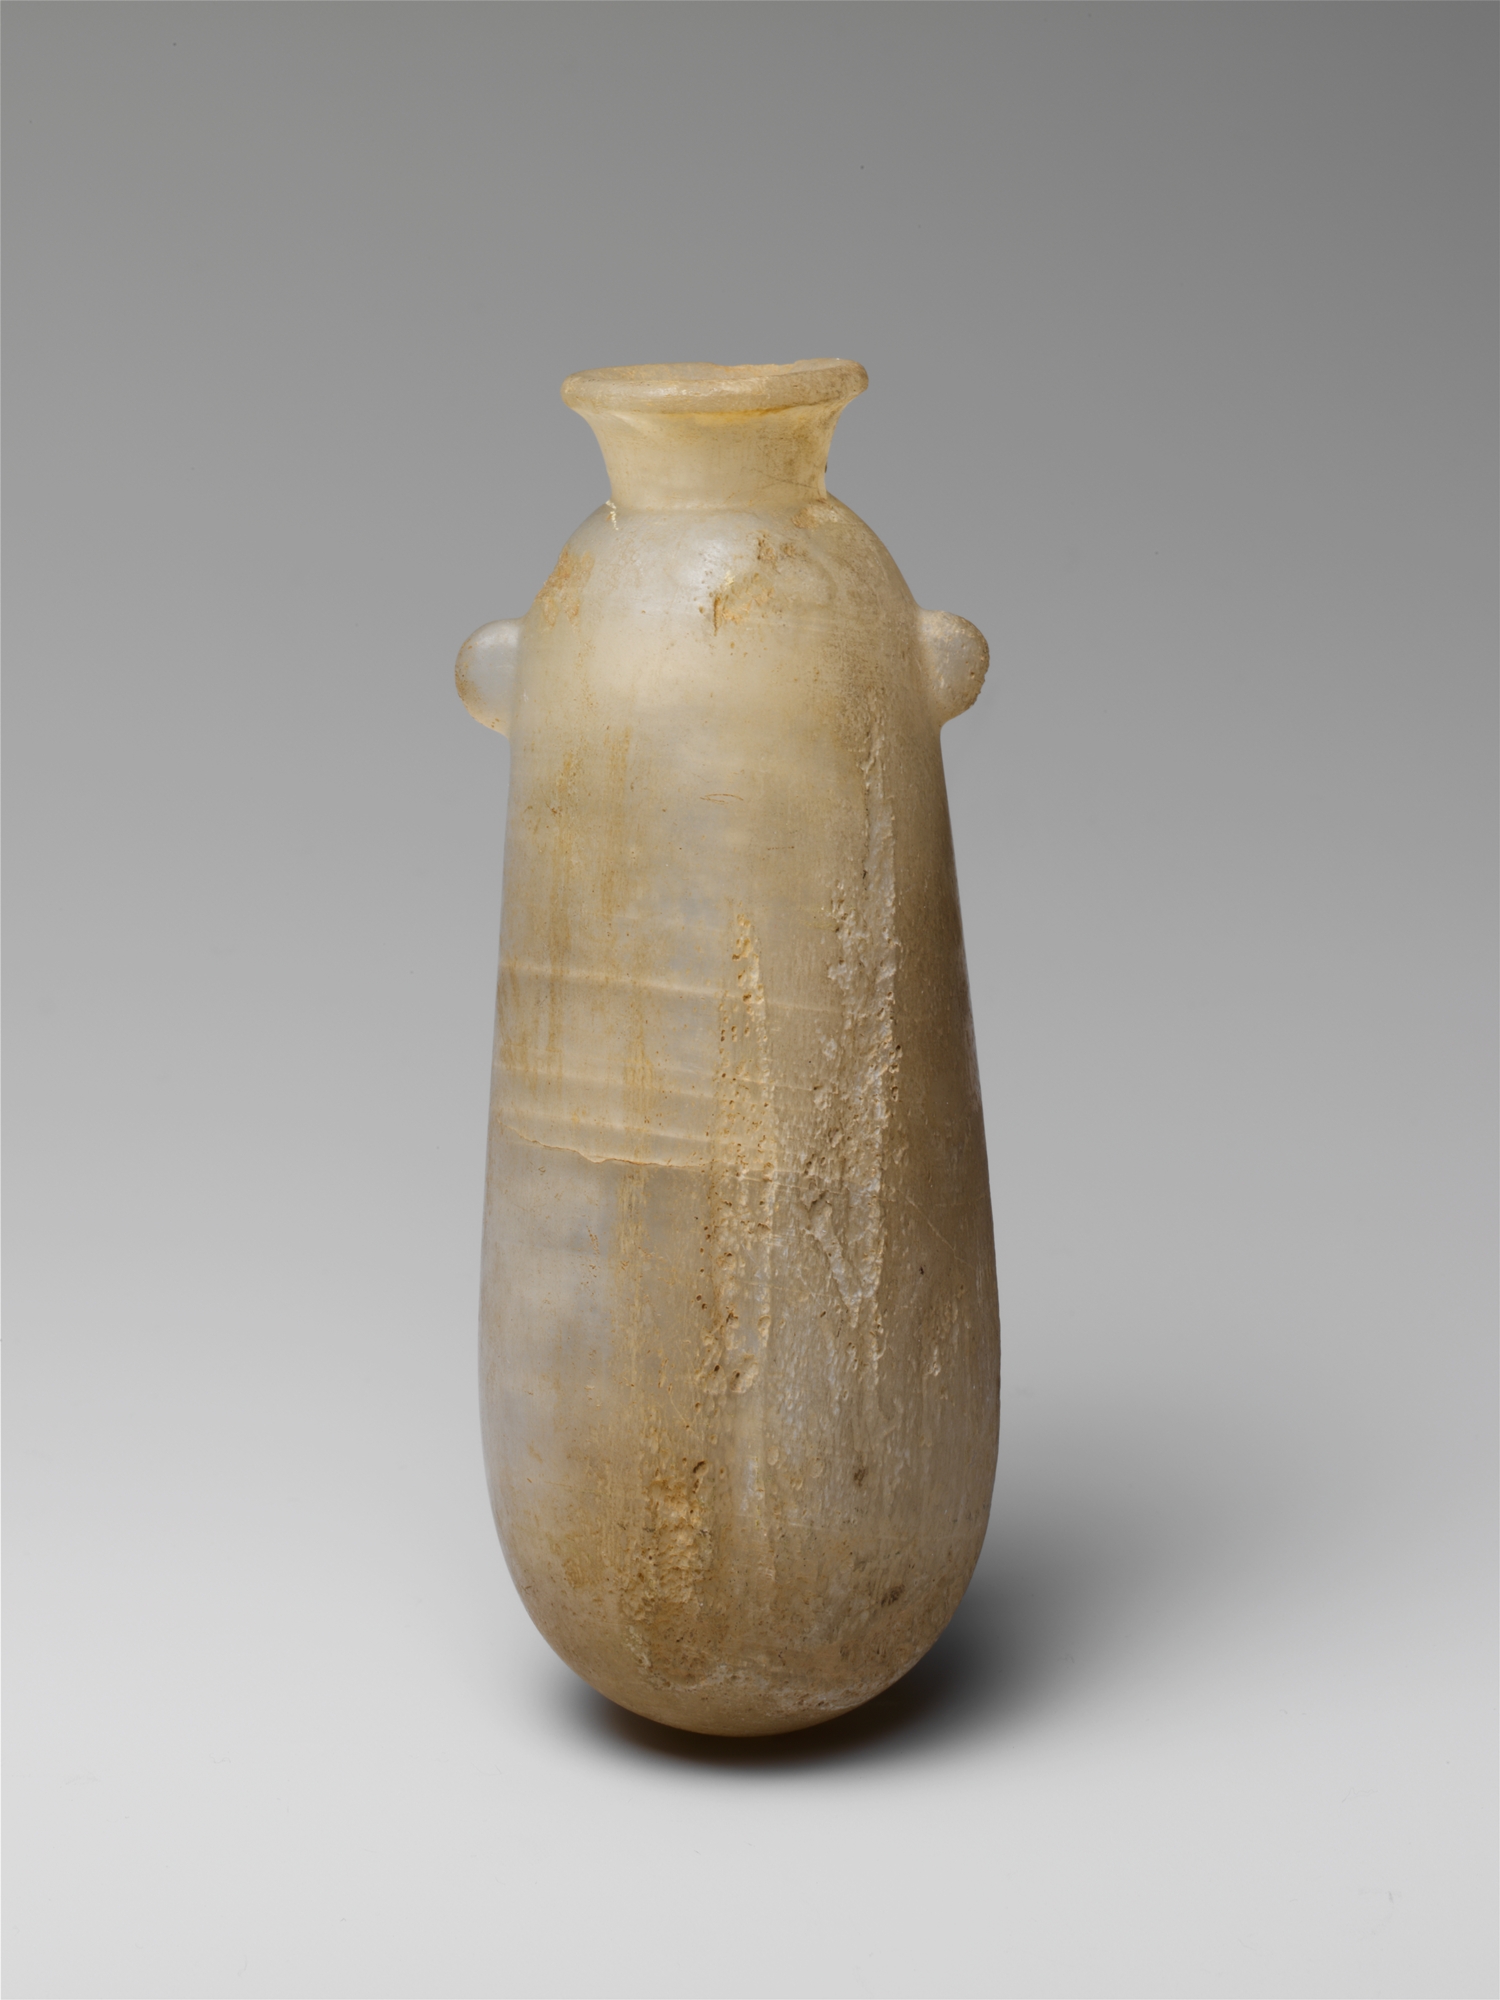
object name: alabastron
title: Alabaster alabastron (perfume vase)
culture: cypriot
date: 600-301 BCE